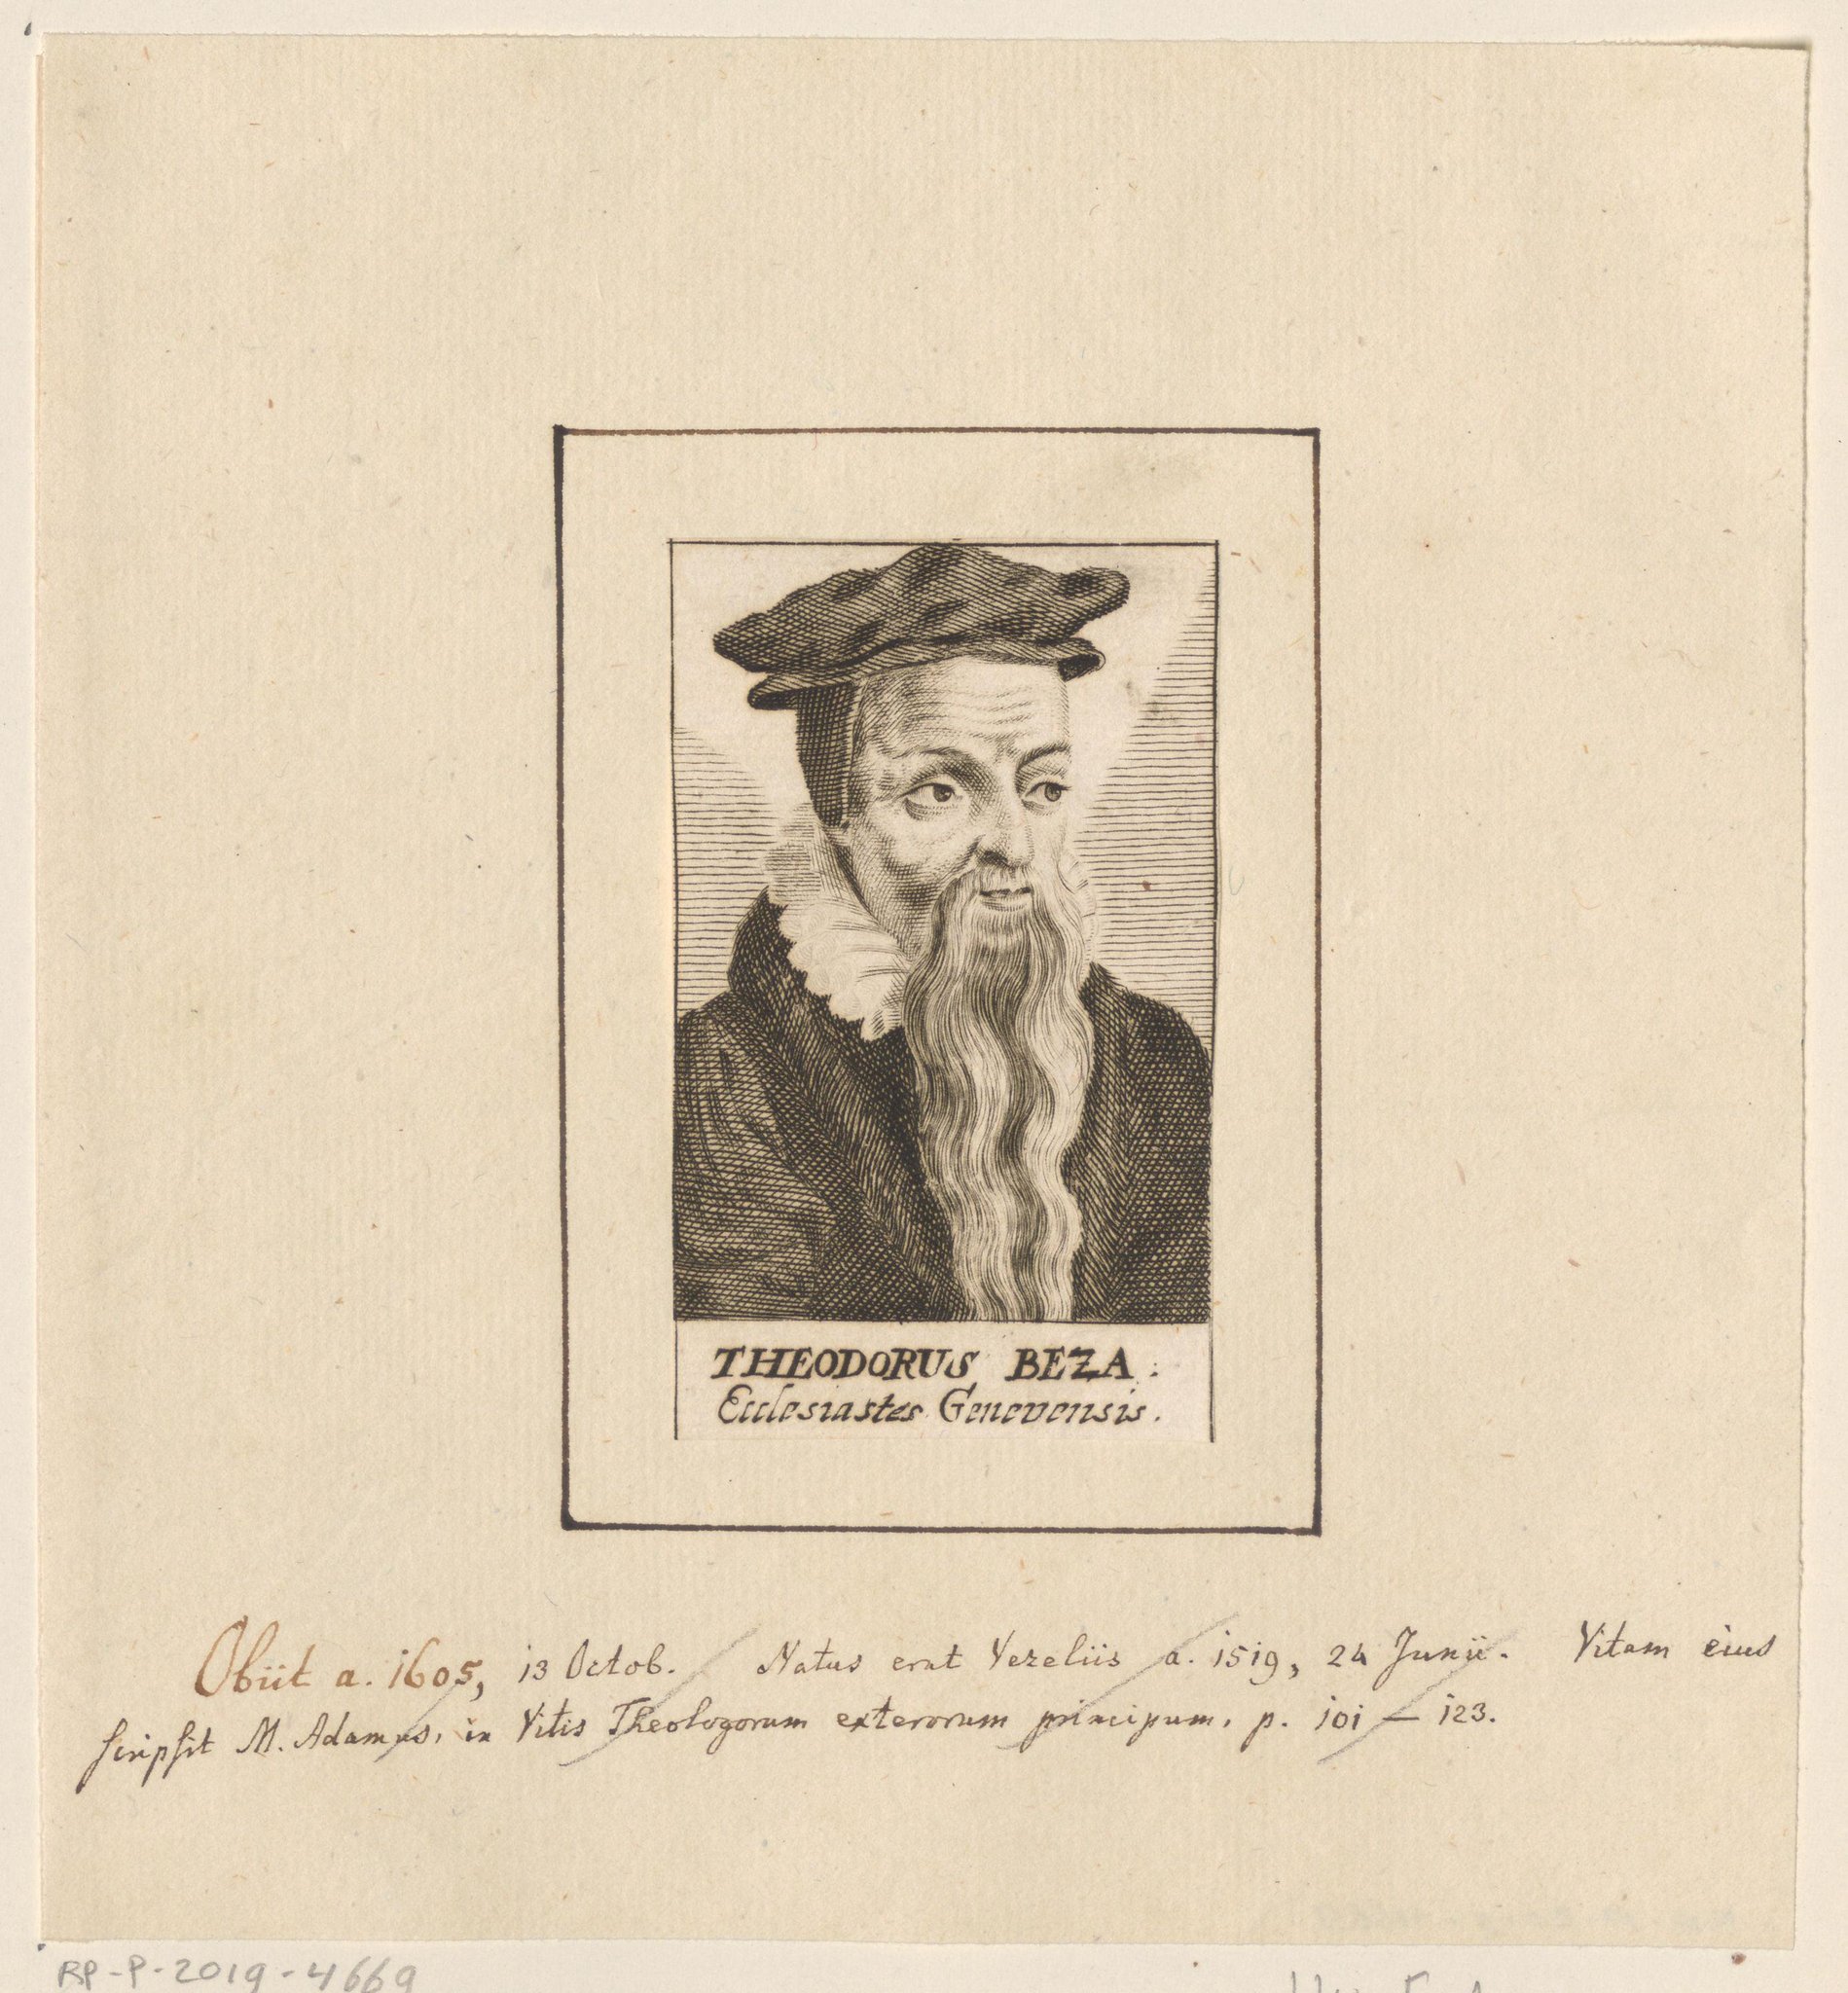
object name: print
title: Portret van Theodorus Beza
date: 1688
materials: paper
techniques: engraving, etching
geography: nuremberg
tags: theodorus beza, theologian, historical persons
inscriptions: inscription: ‘Obiit a. 1605, 13 Octob. [...]’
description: Prent uit: Freher, Paul. Theatrum virorum eruditione clarorum. Neurenberg: Johann Hoffmann, 1688.